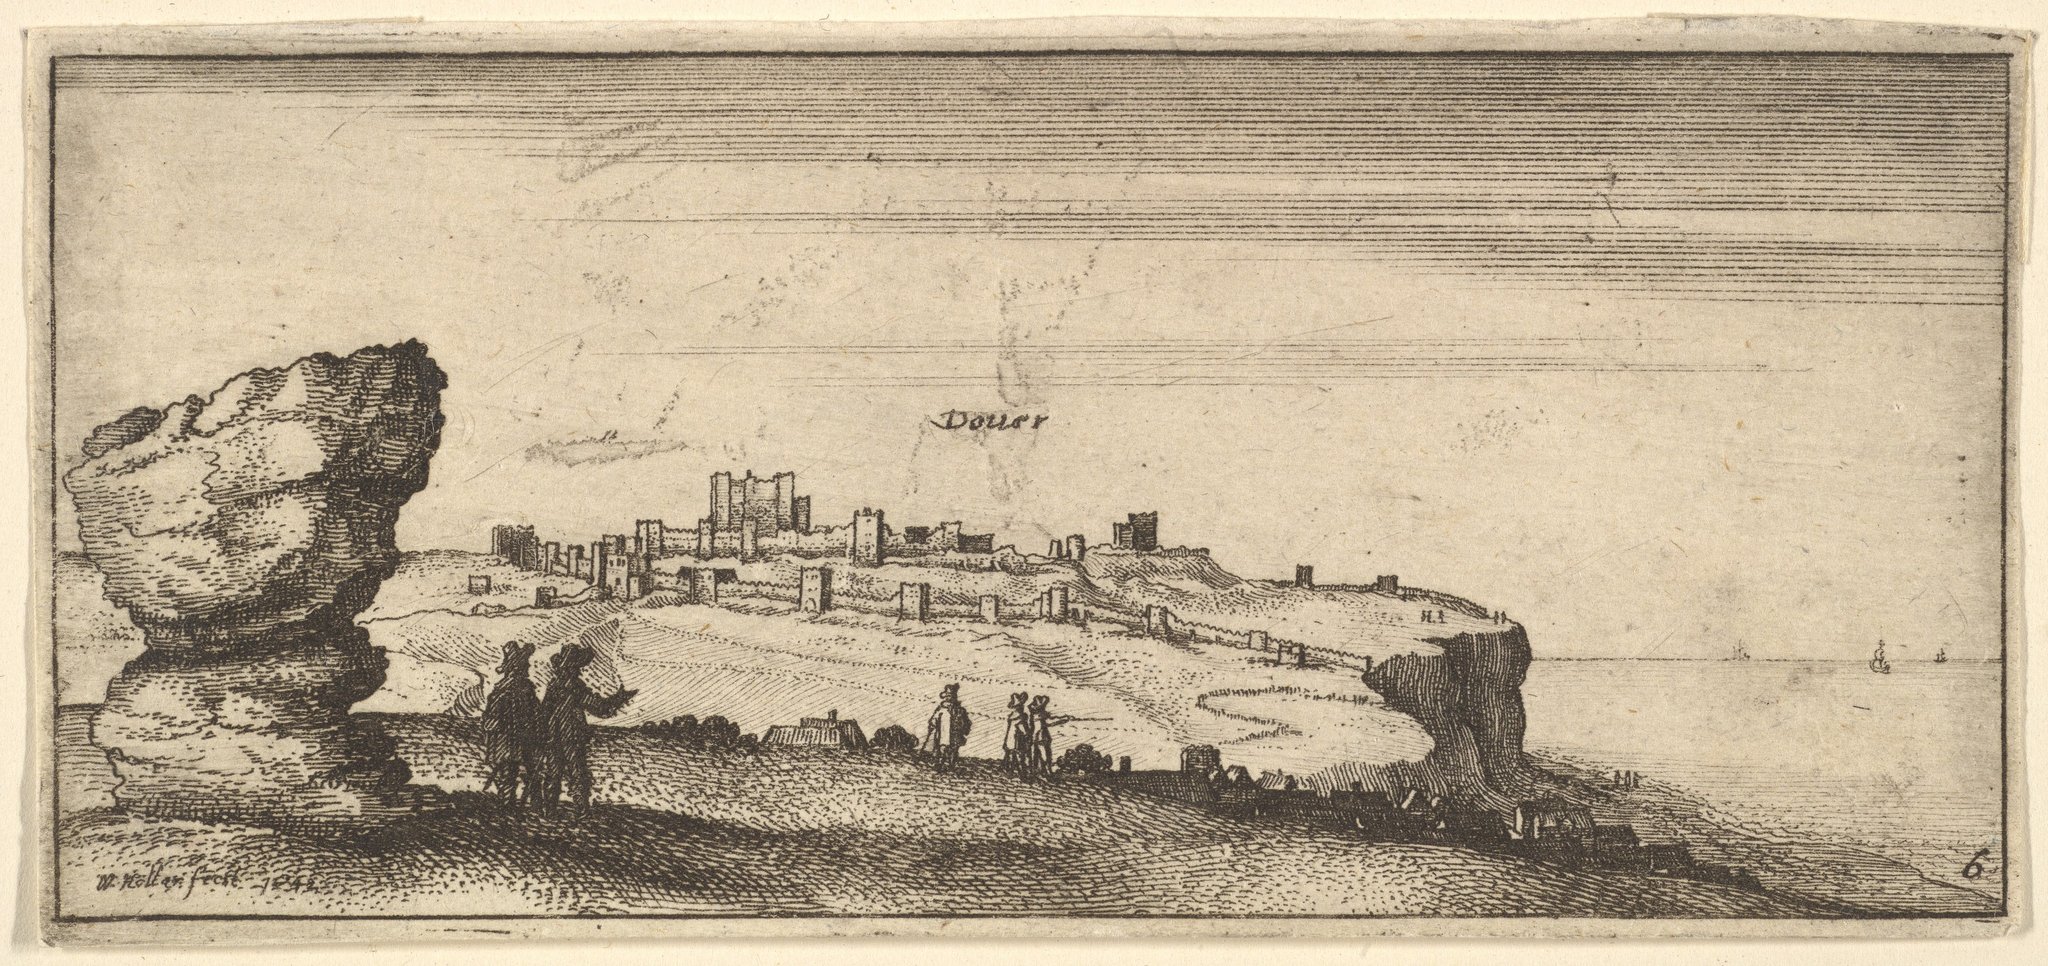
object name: print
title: Douer (Dover), from "English Views"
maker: wenceslaus hollar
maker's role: artist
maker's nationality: bohemian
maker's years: 1607-1677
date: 1642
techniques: etching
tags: human figures,castles,fortification,ships